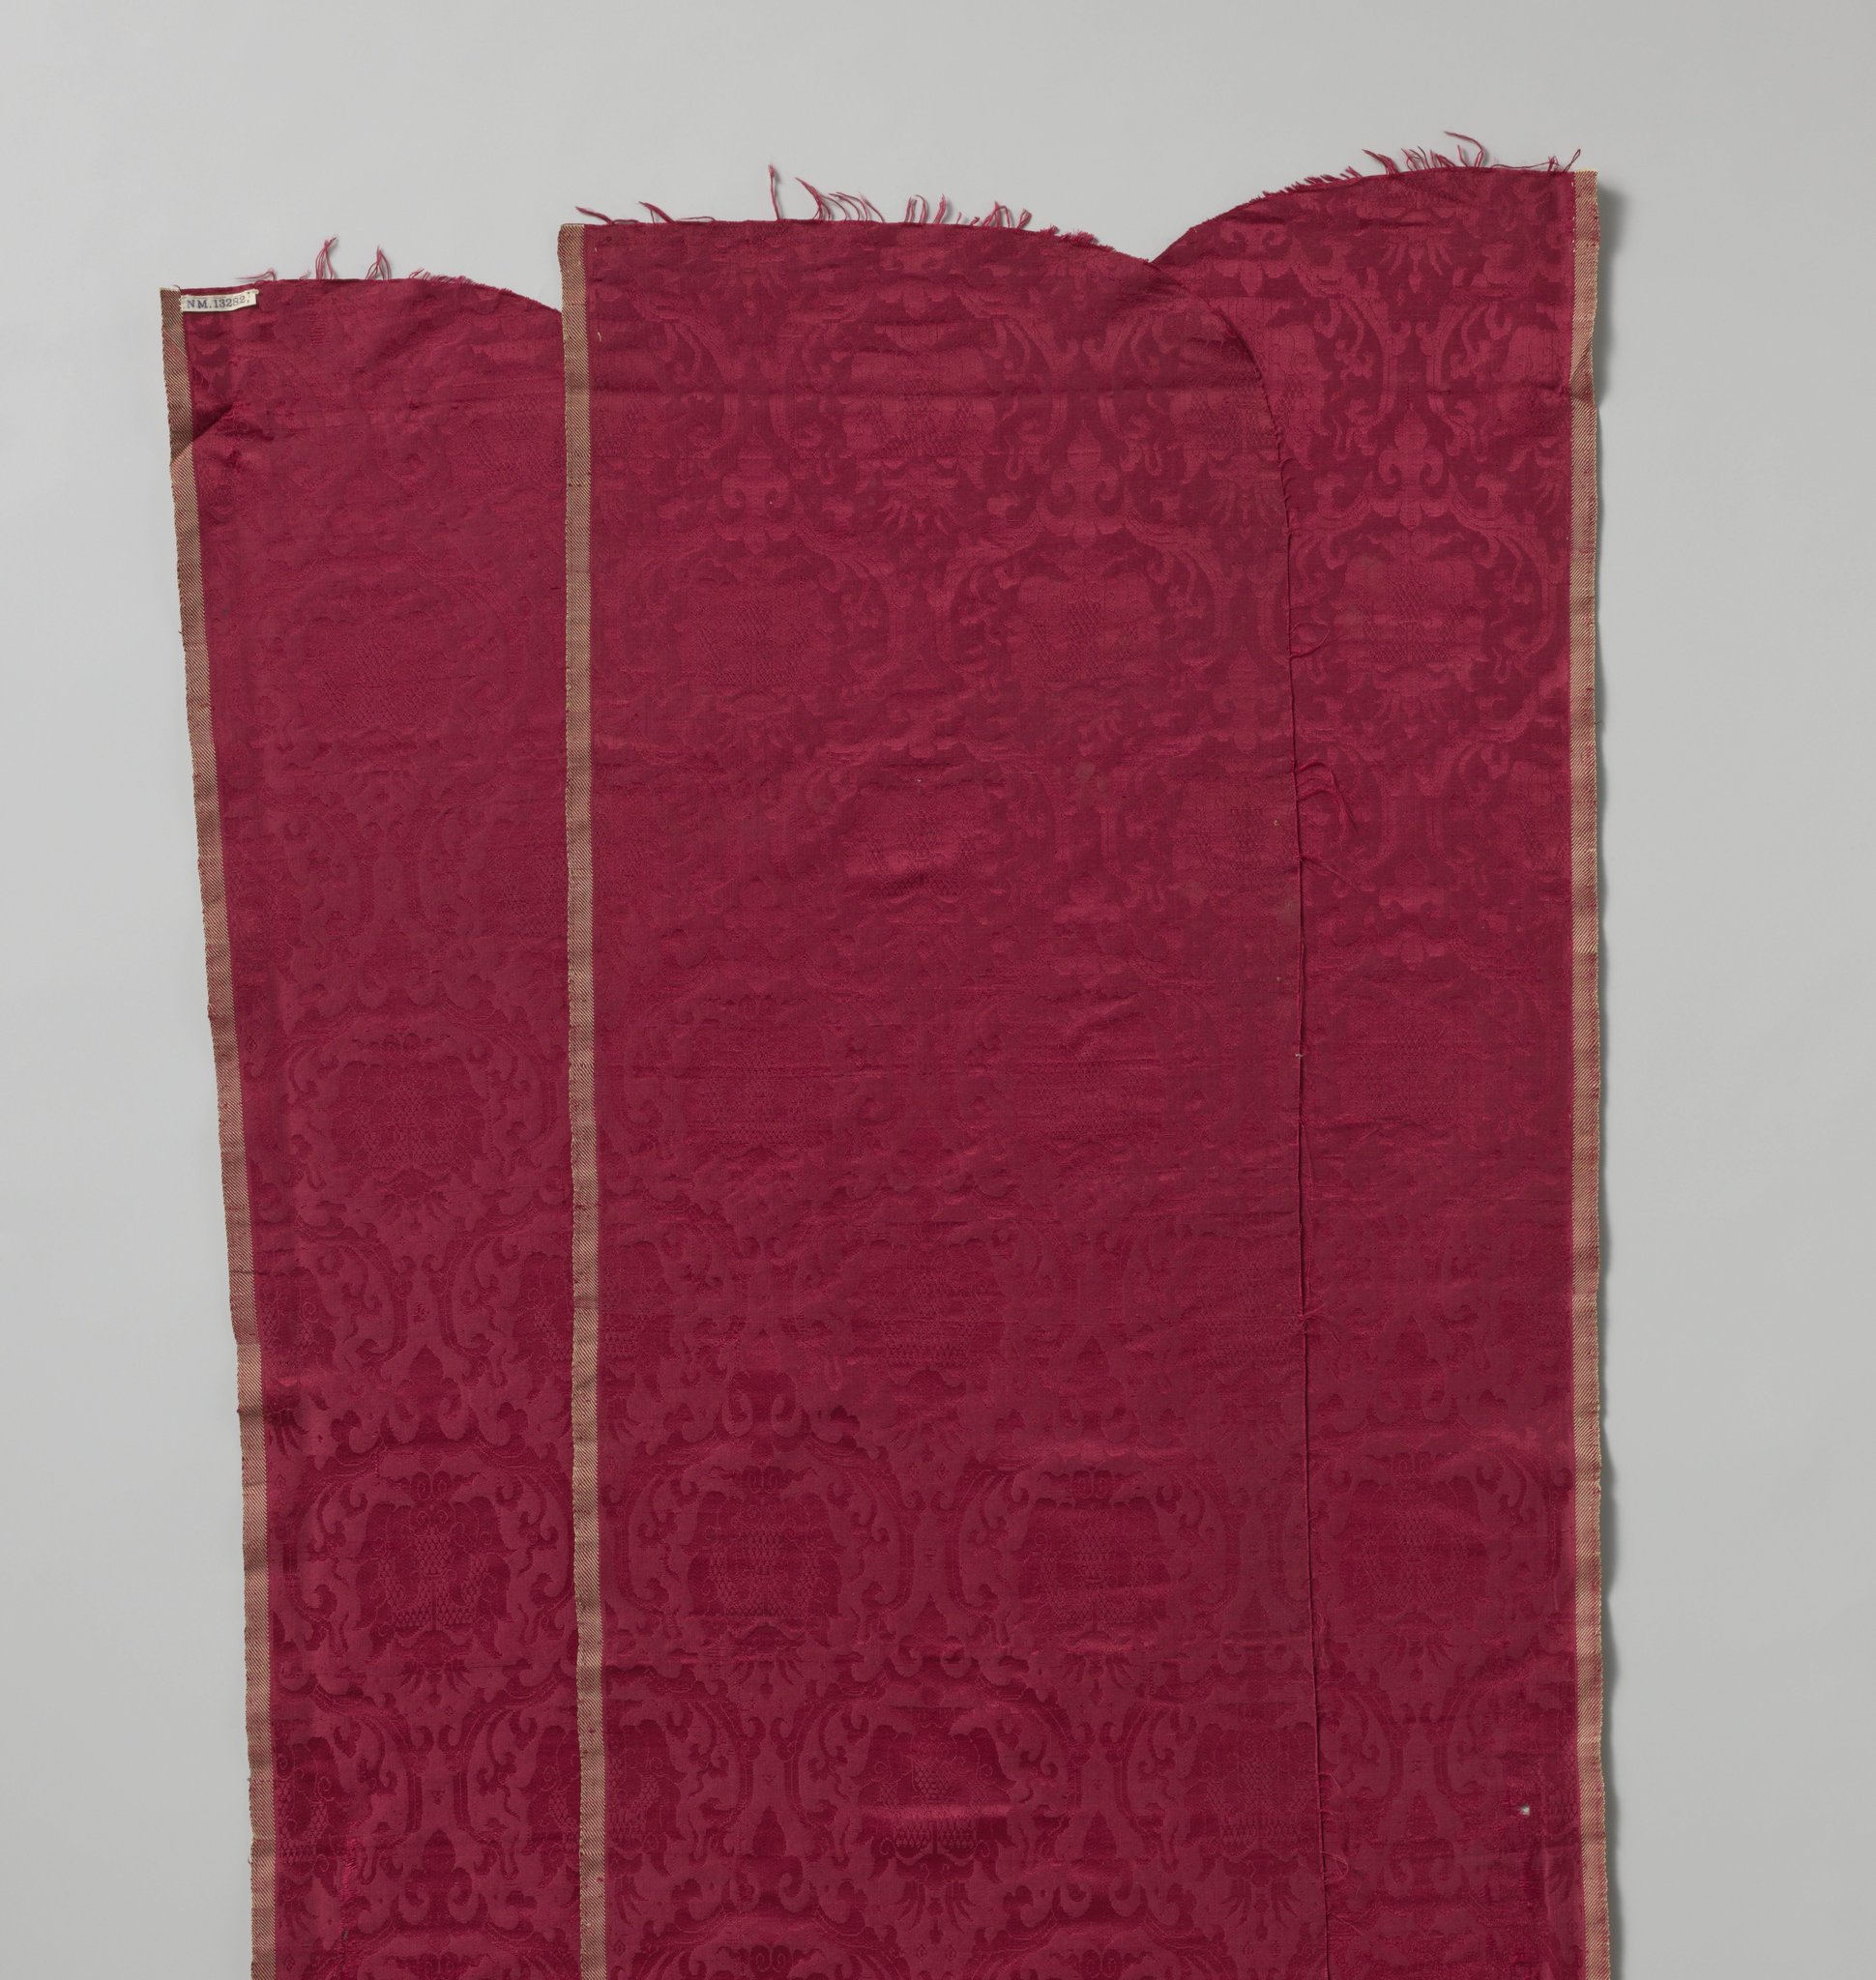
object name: zijdedamast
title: Vijf aan elkaar genaaide fragmenten rood zijdedamast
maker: Anonymous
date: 1500-1699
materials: silk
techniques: damask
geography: china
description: Vijf fragmenten van rood zijdeweefsel met een patroon van verspringende rijen palmetten met een wolkenband-motief, in omsluitende rank uitkomend in een omgekeerde franse lelie. Oosters textiel.